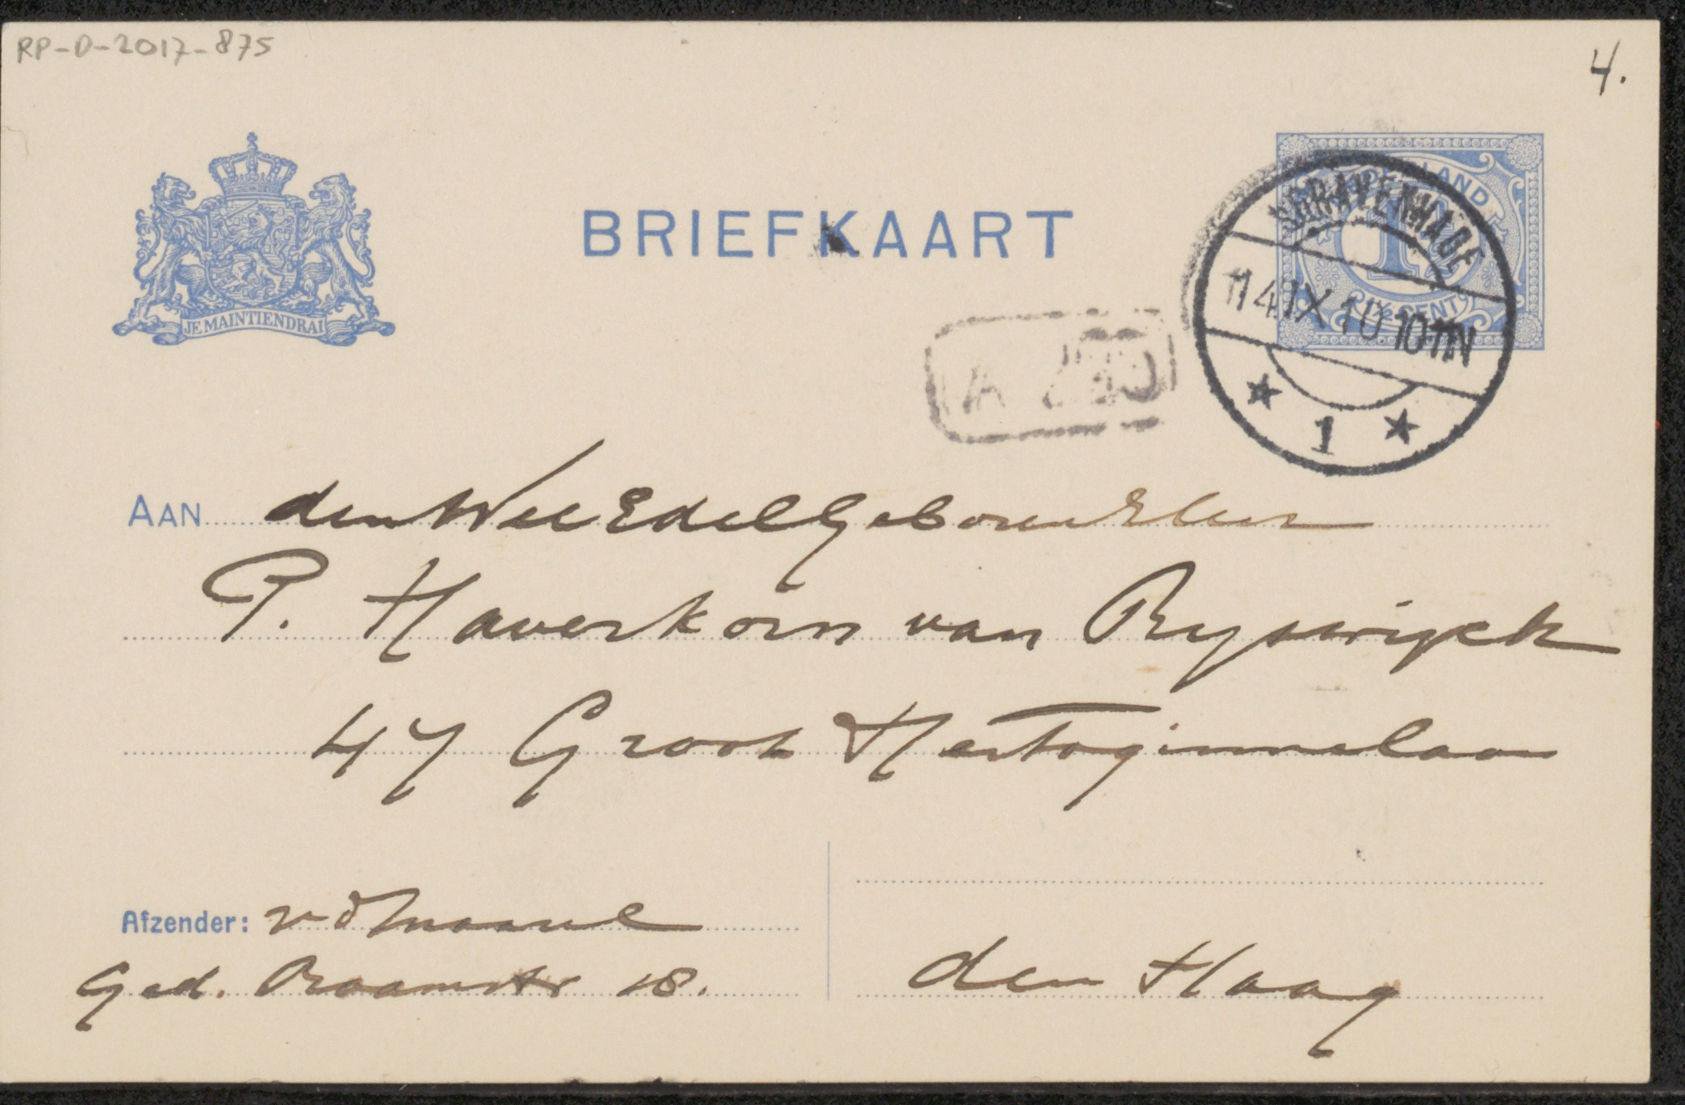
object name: postcard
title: Briefkaart aan Pieter Haverkorn van Rijsewijk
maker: marinus van der maarel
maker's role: draughtsman, painter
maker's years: 1857-1921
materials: cardboard, ink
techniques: pen, writing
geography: the hague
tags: pieter haverkorn van rijsewijk, drawing